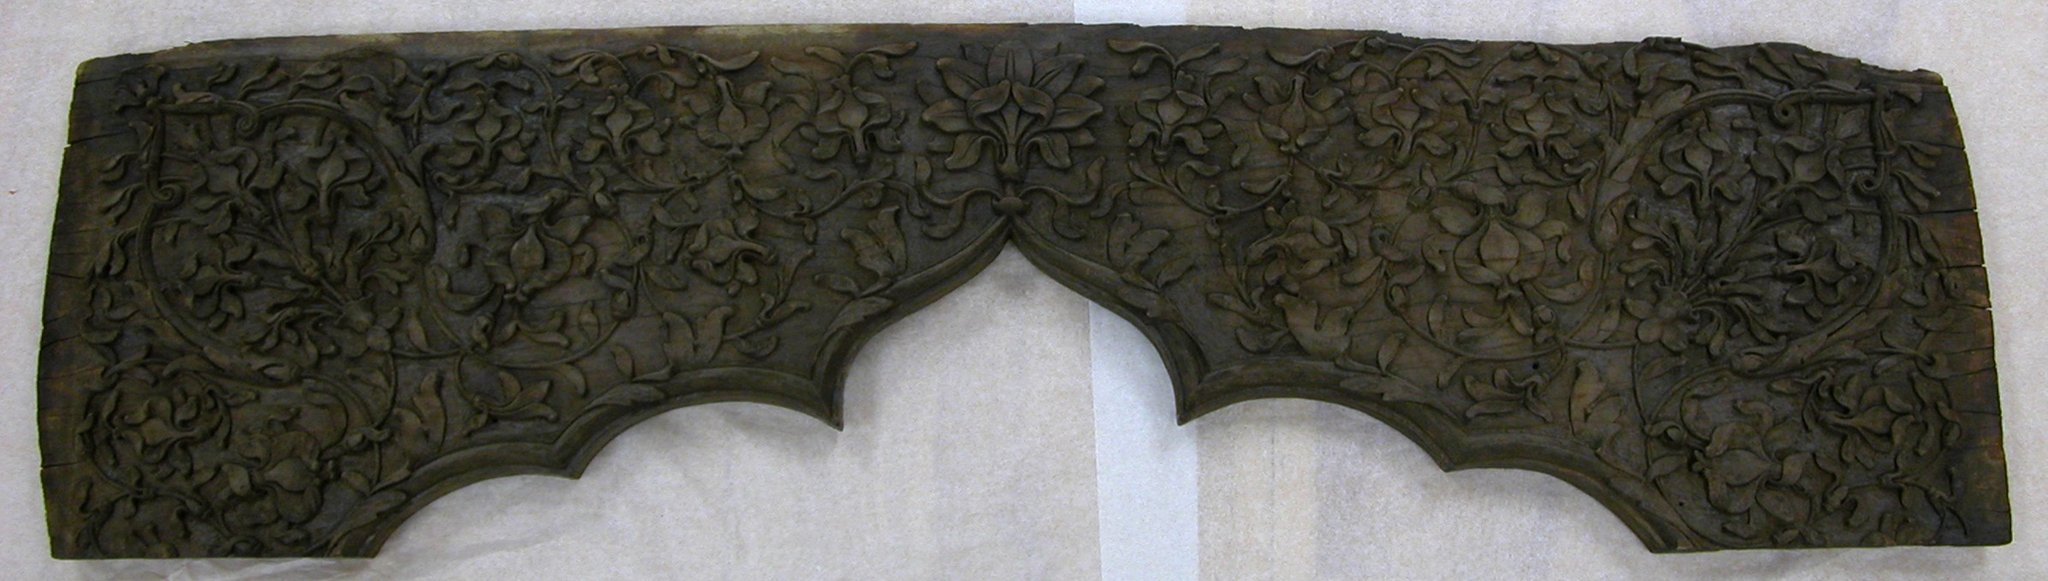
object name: archway section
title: Section of an Archway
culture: indian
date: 1651-1700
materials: wood